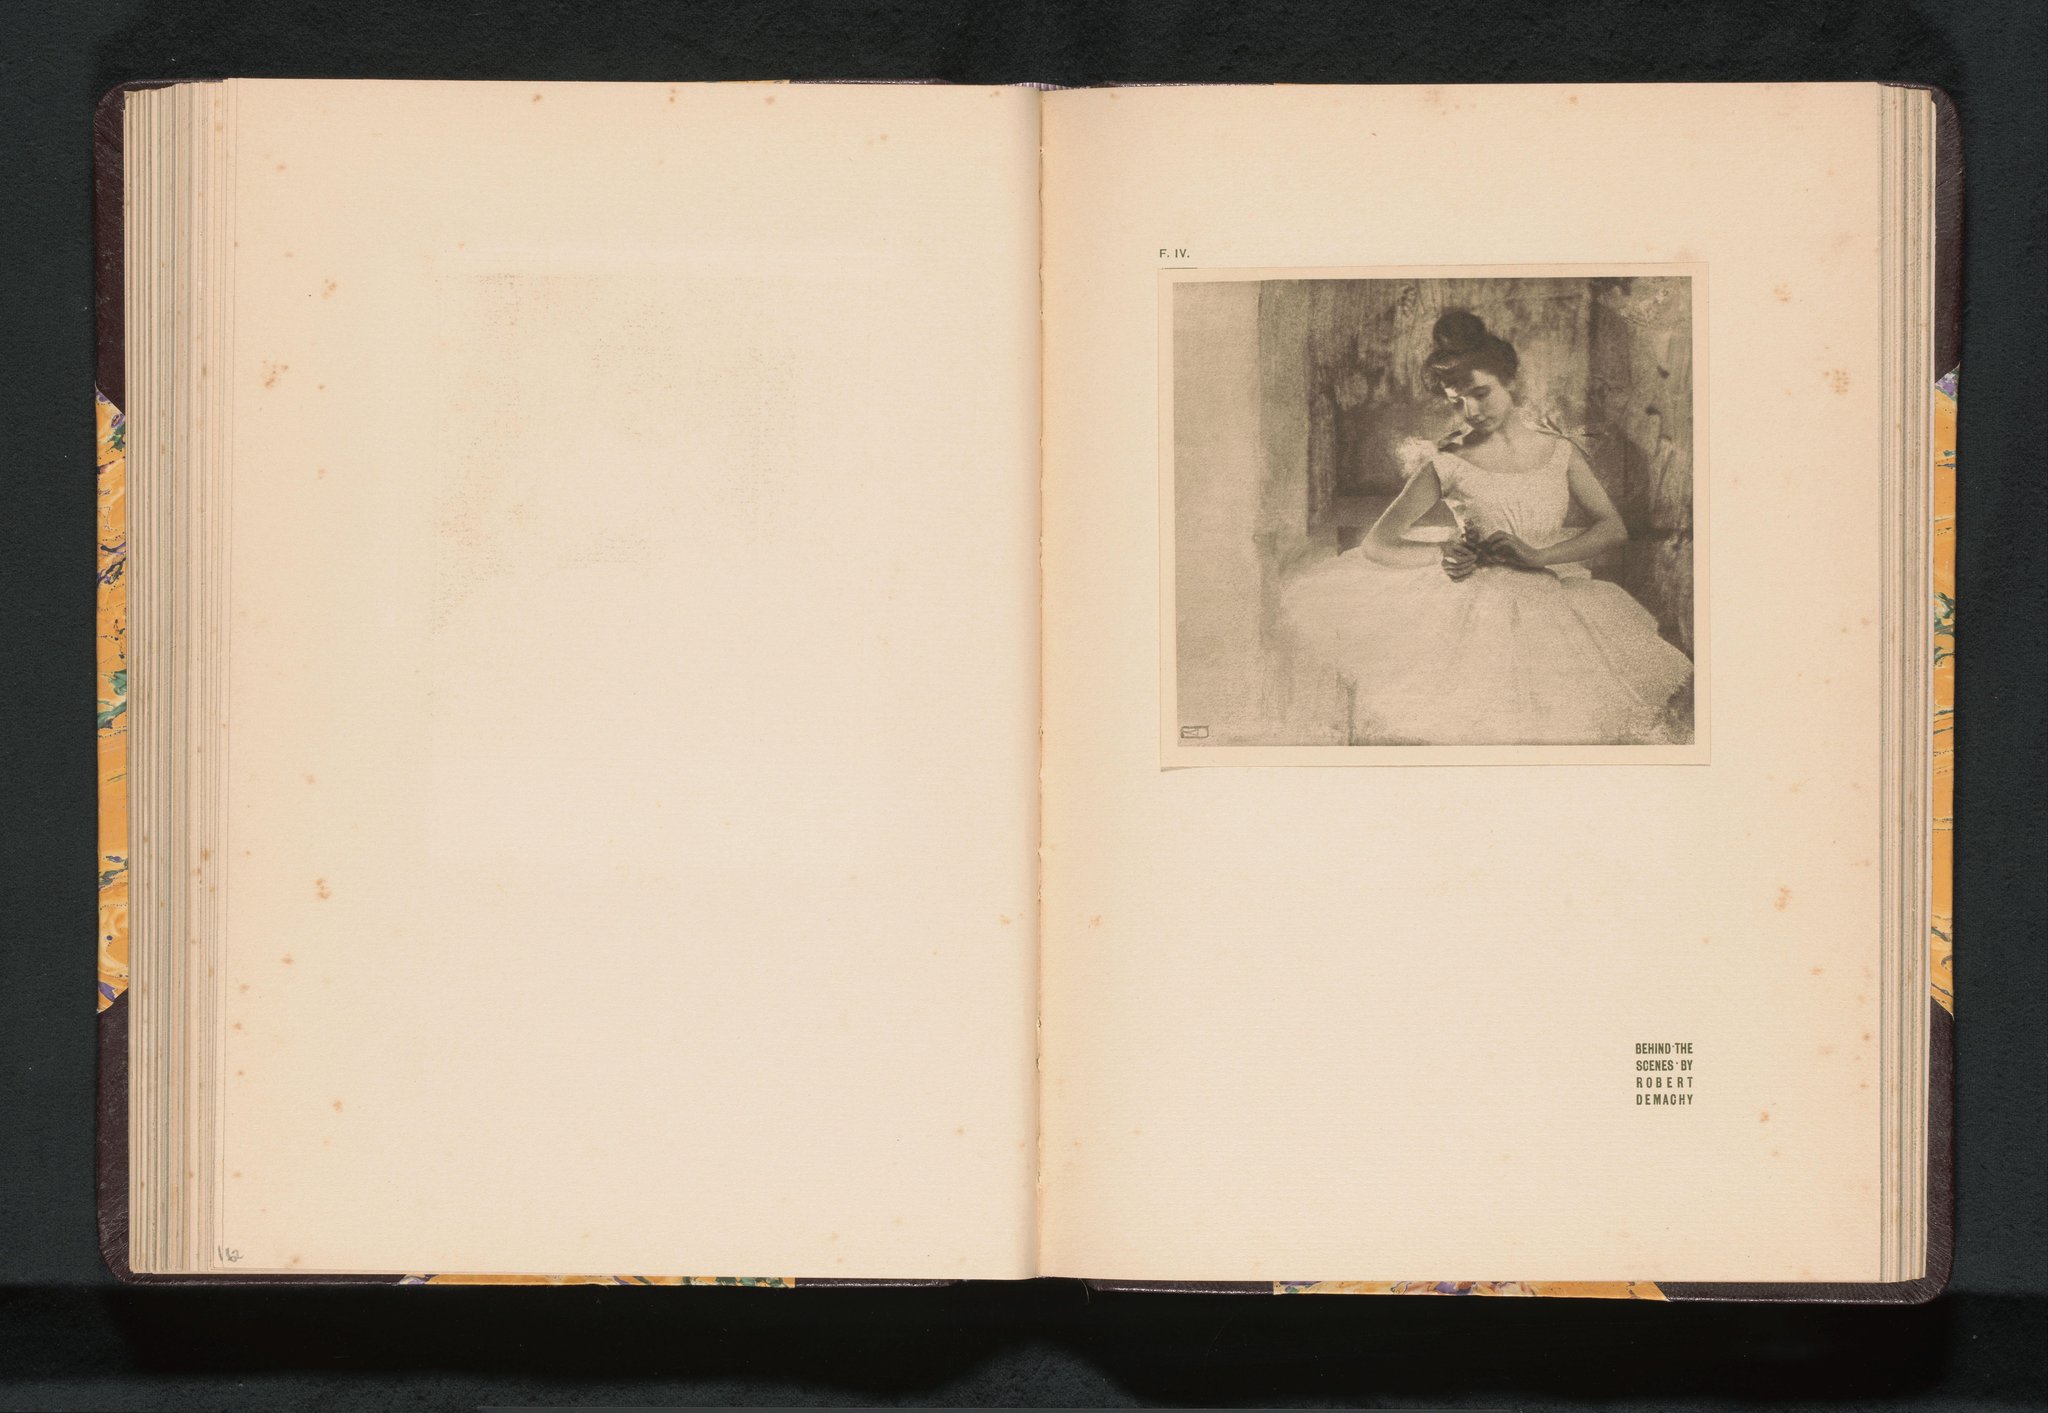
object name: page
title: Ballerina achter de schermen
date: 1900-1905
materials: paper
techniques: photoaquatint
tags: adolescent, young woman, maiden, female dancer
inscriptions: inscription: ‘F. IV.’, inscription: ‘Behind the scenes by Robert Demachy’